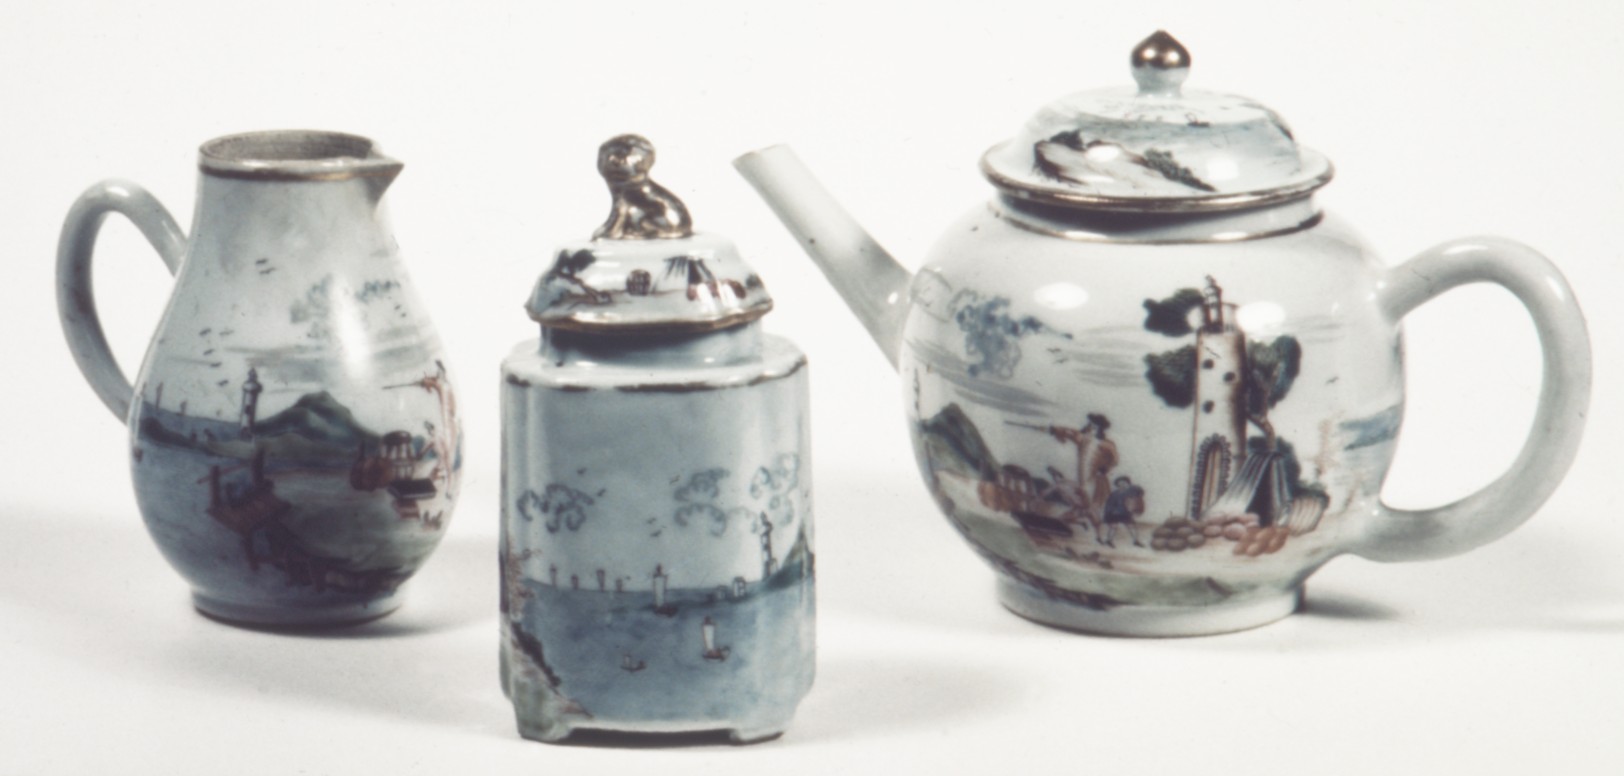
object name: teapot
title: Teapot (part of a service)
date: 1750-1770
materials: hard paste porcelain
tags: men